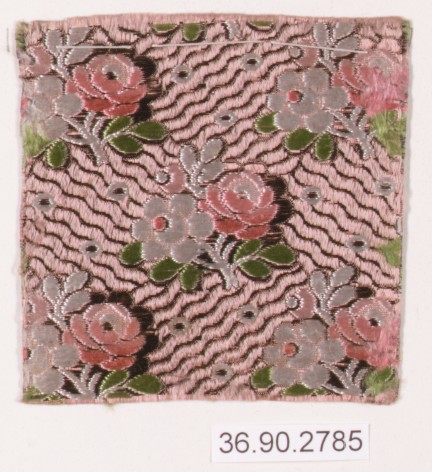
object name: piece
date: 1801-1900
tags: flowers,leaves